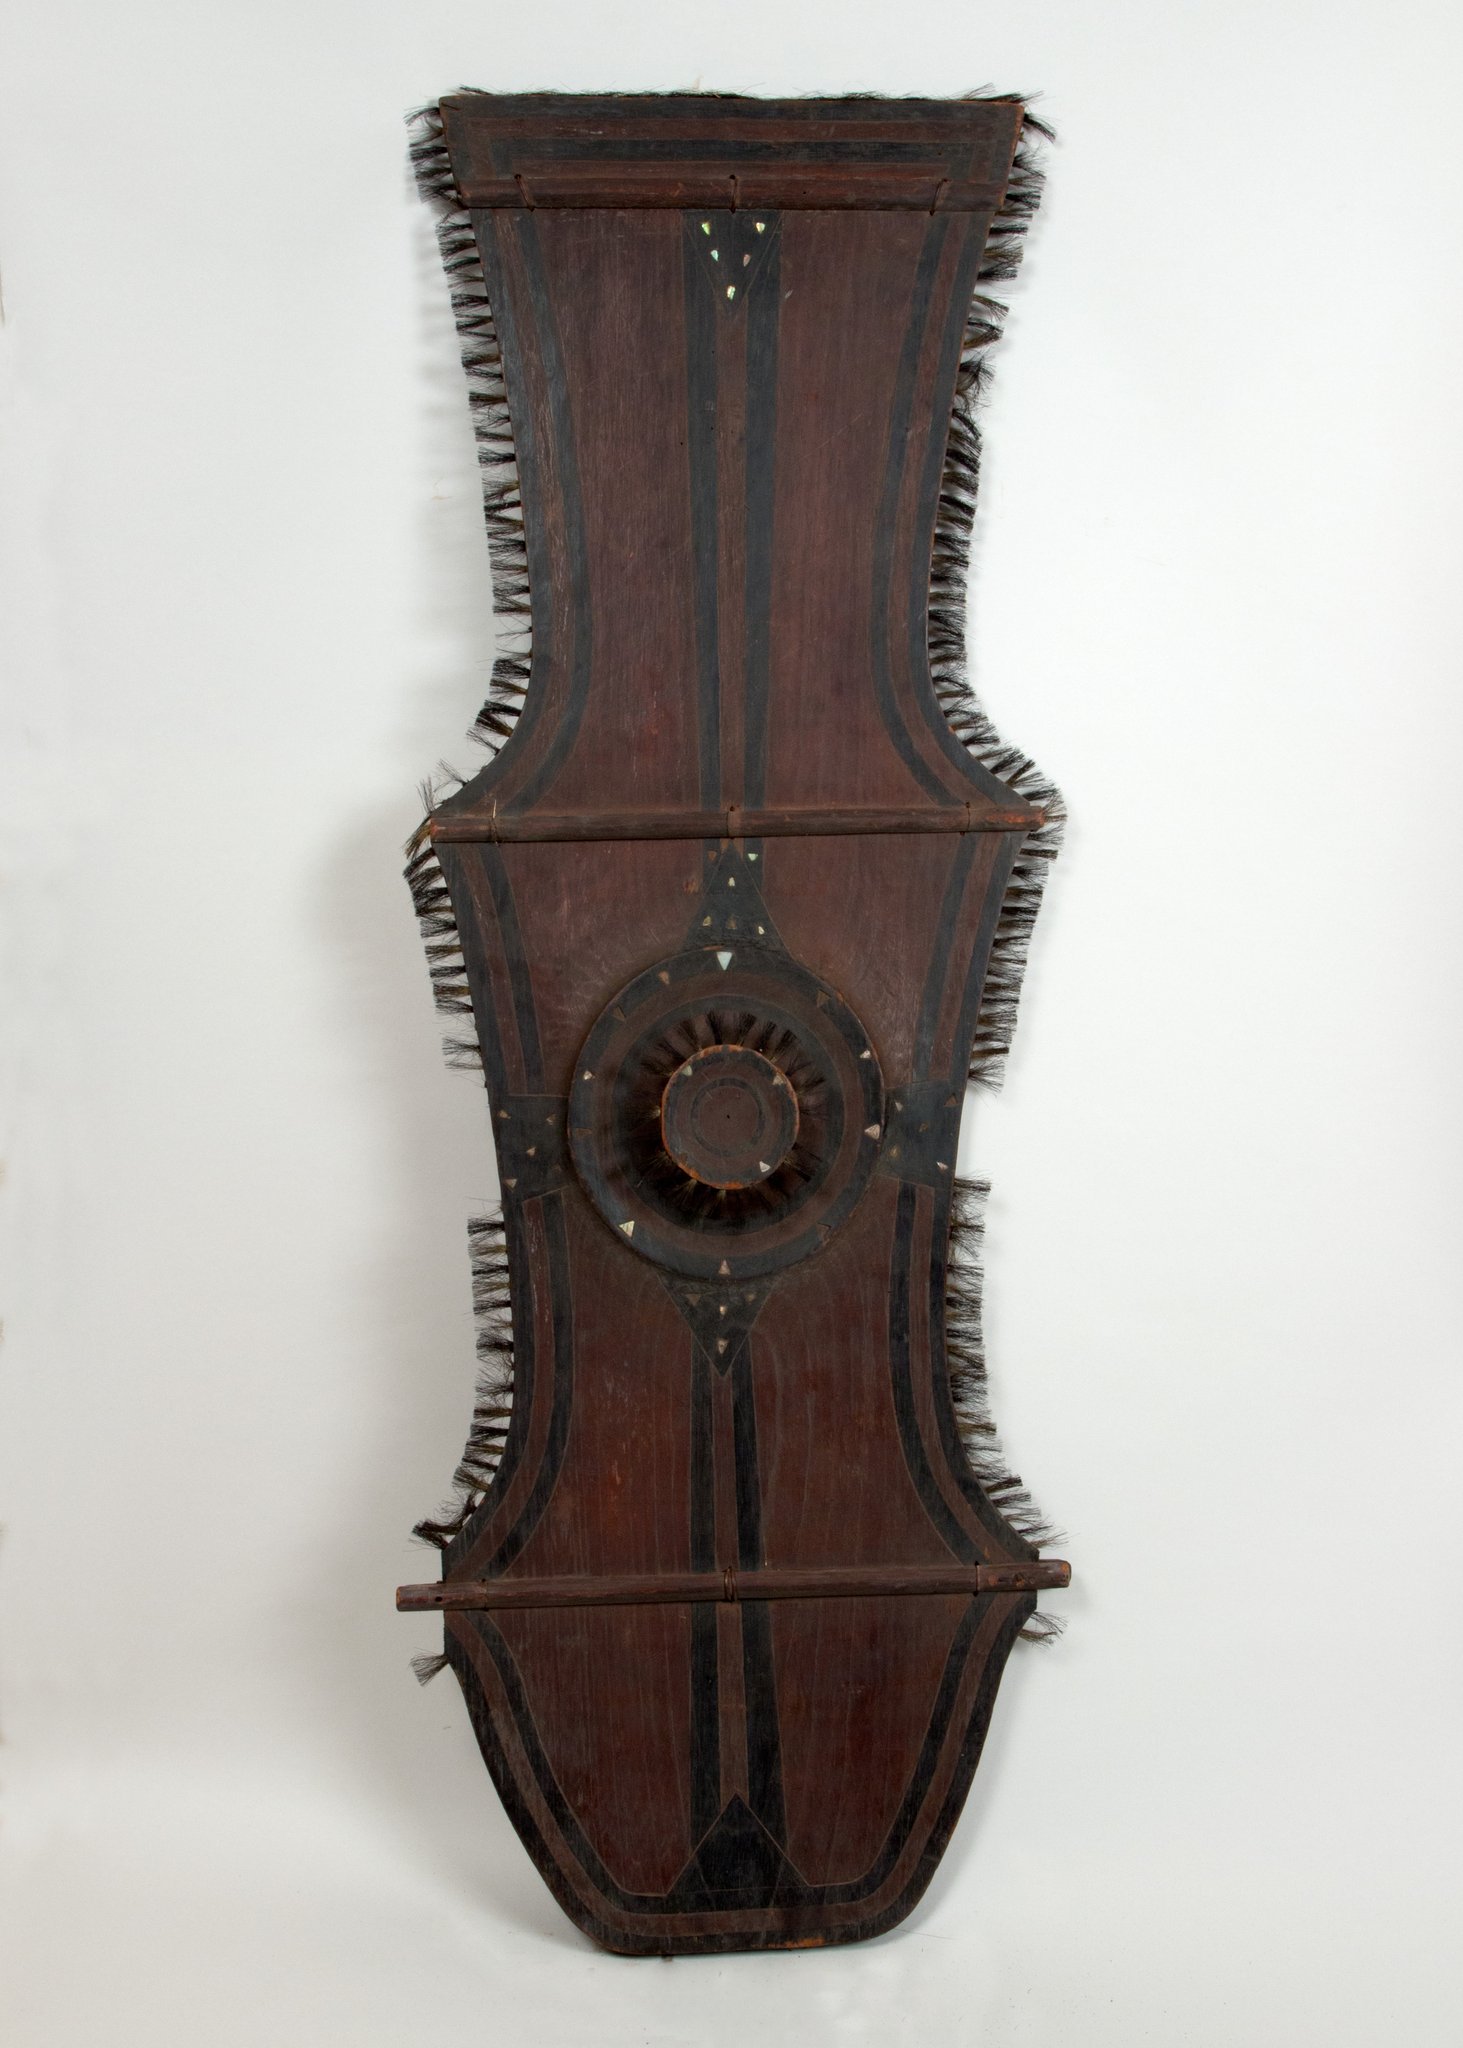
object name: shield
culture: philippine, bagobo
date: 1701-1900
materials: hair, pigment, shell, wood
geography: philippines